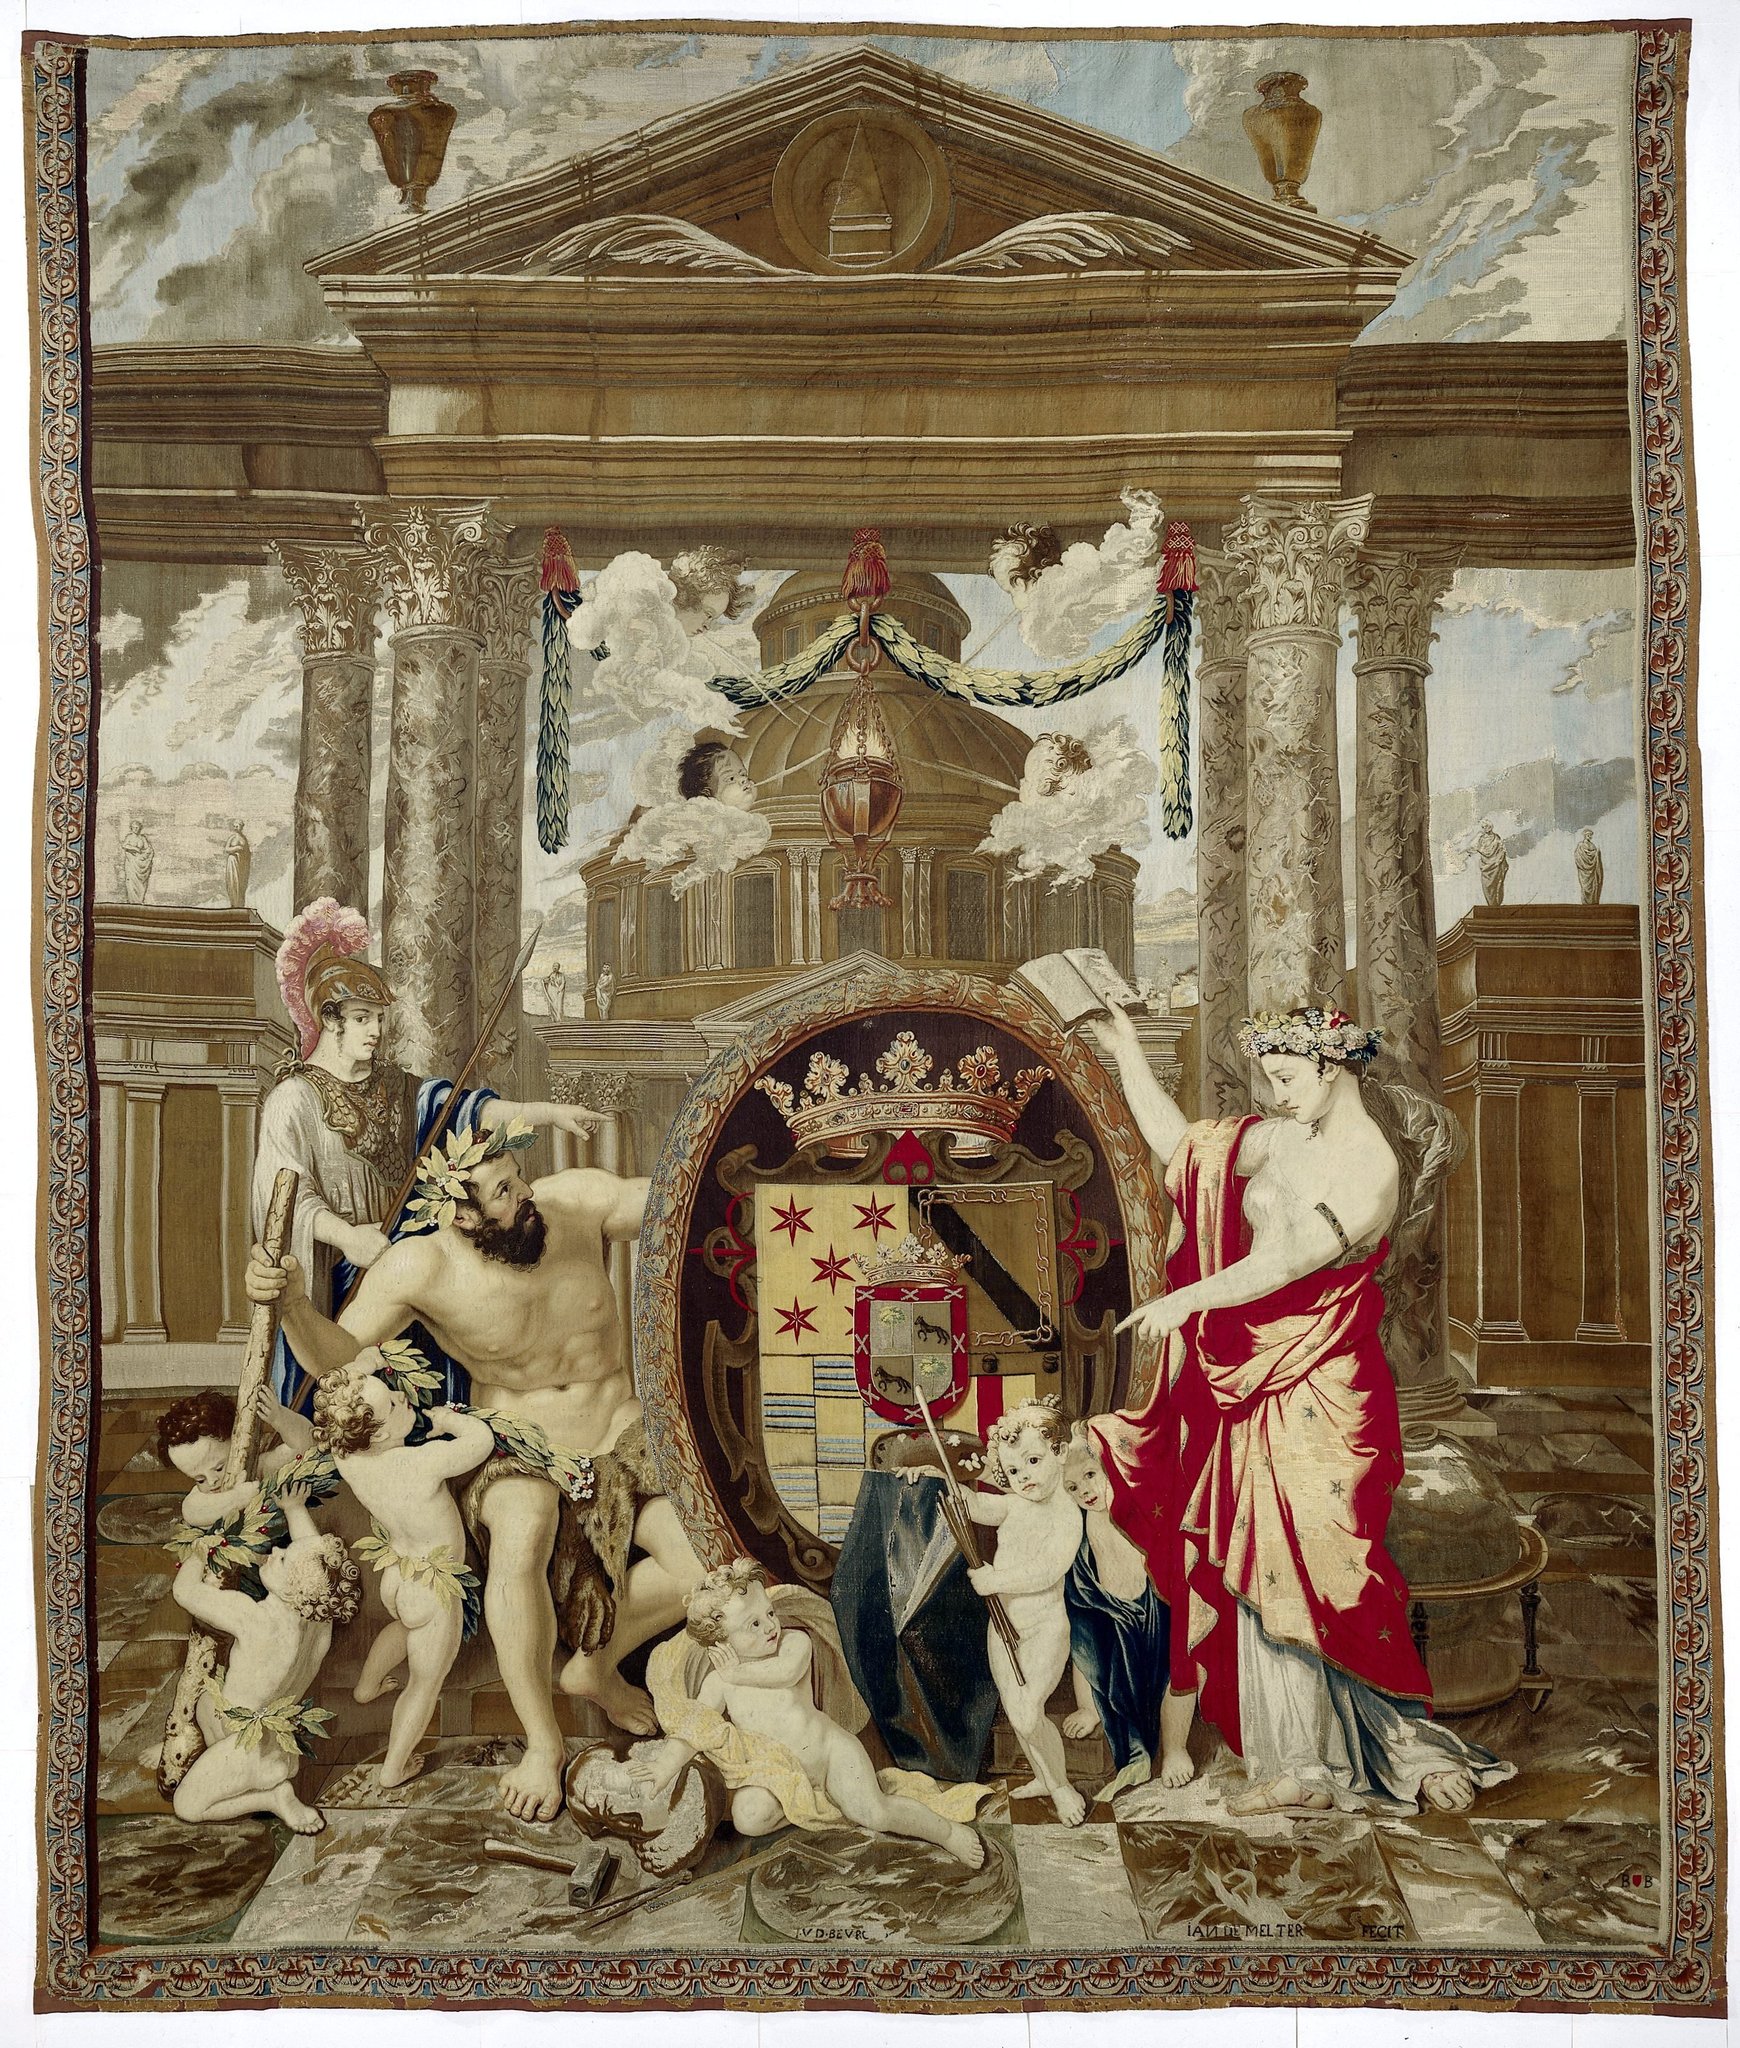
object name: tapestry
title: Wapentapijt van de graaf van Monterey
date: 1675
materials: metal thread, silk, wool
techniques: tapestry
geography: brussels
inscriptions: signature: ‘I.V.D.BEVRC[HT] IAN DE MELTER FECIT’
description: Tapestry. Wool, silk and silver thread. Brussels, c. 1675, workshops of Jan de Melter and possibly Jakob van de Borcht. Marked: B B (Brabant Brussels), signed: I.V.D. BEVCHT / IAN.DE.MELTER / FECIT. The arms in the centre of the tapestry are those of Don Juan-Domingo de Zuñiga y Fonseca, Count of Monterey e Fuentes, Governor of the Southern Netherlands from 1670 to 1675.